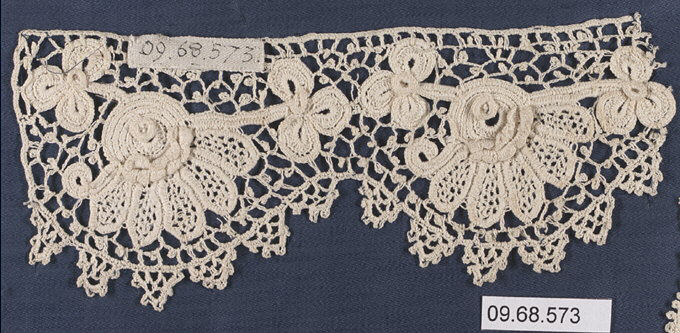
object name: specimen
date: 1801-1900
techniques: crochet